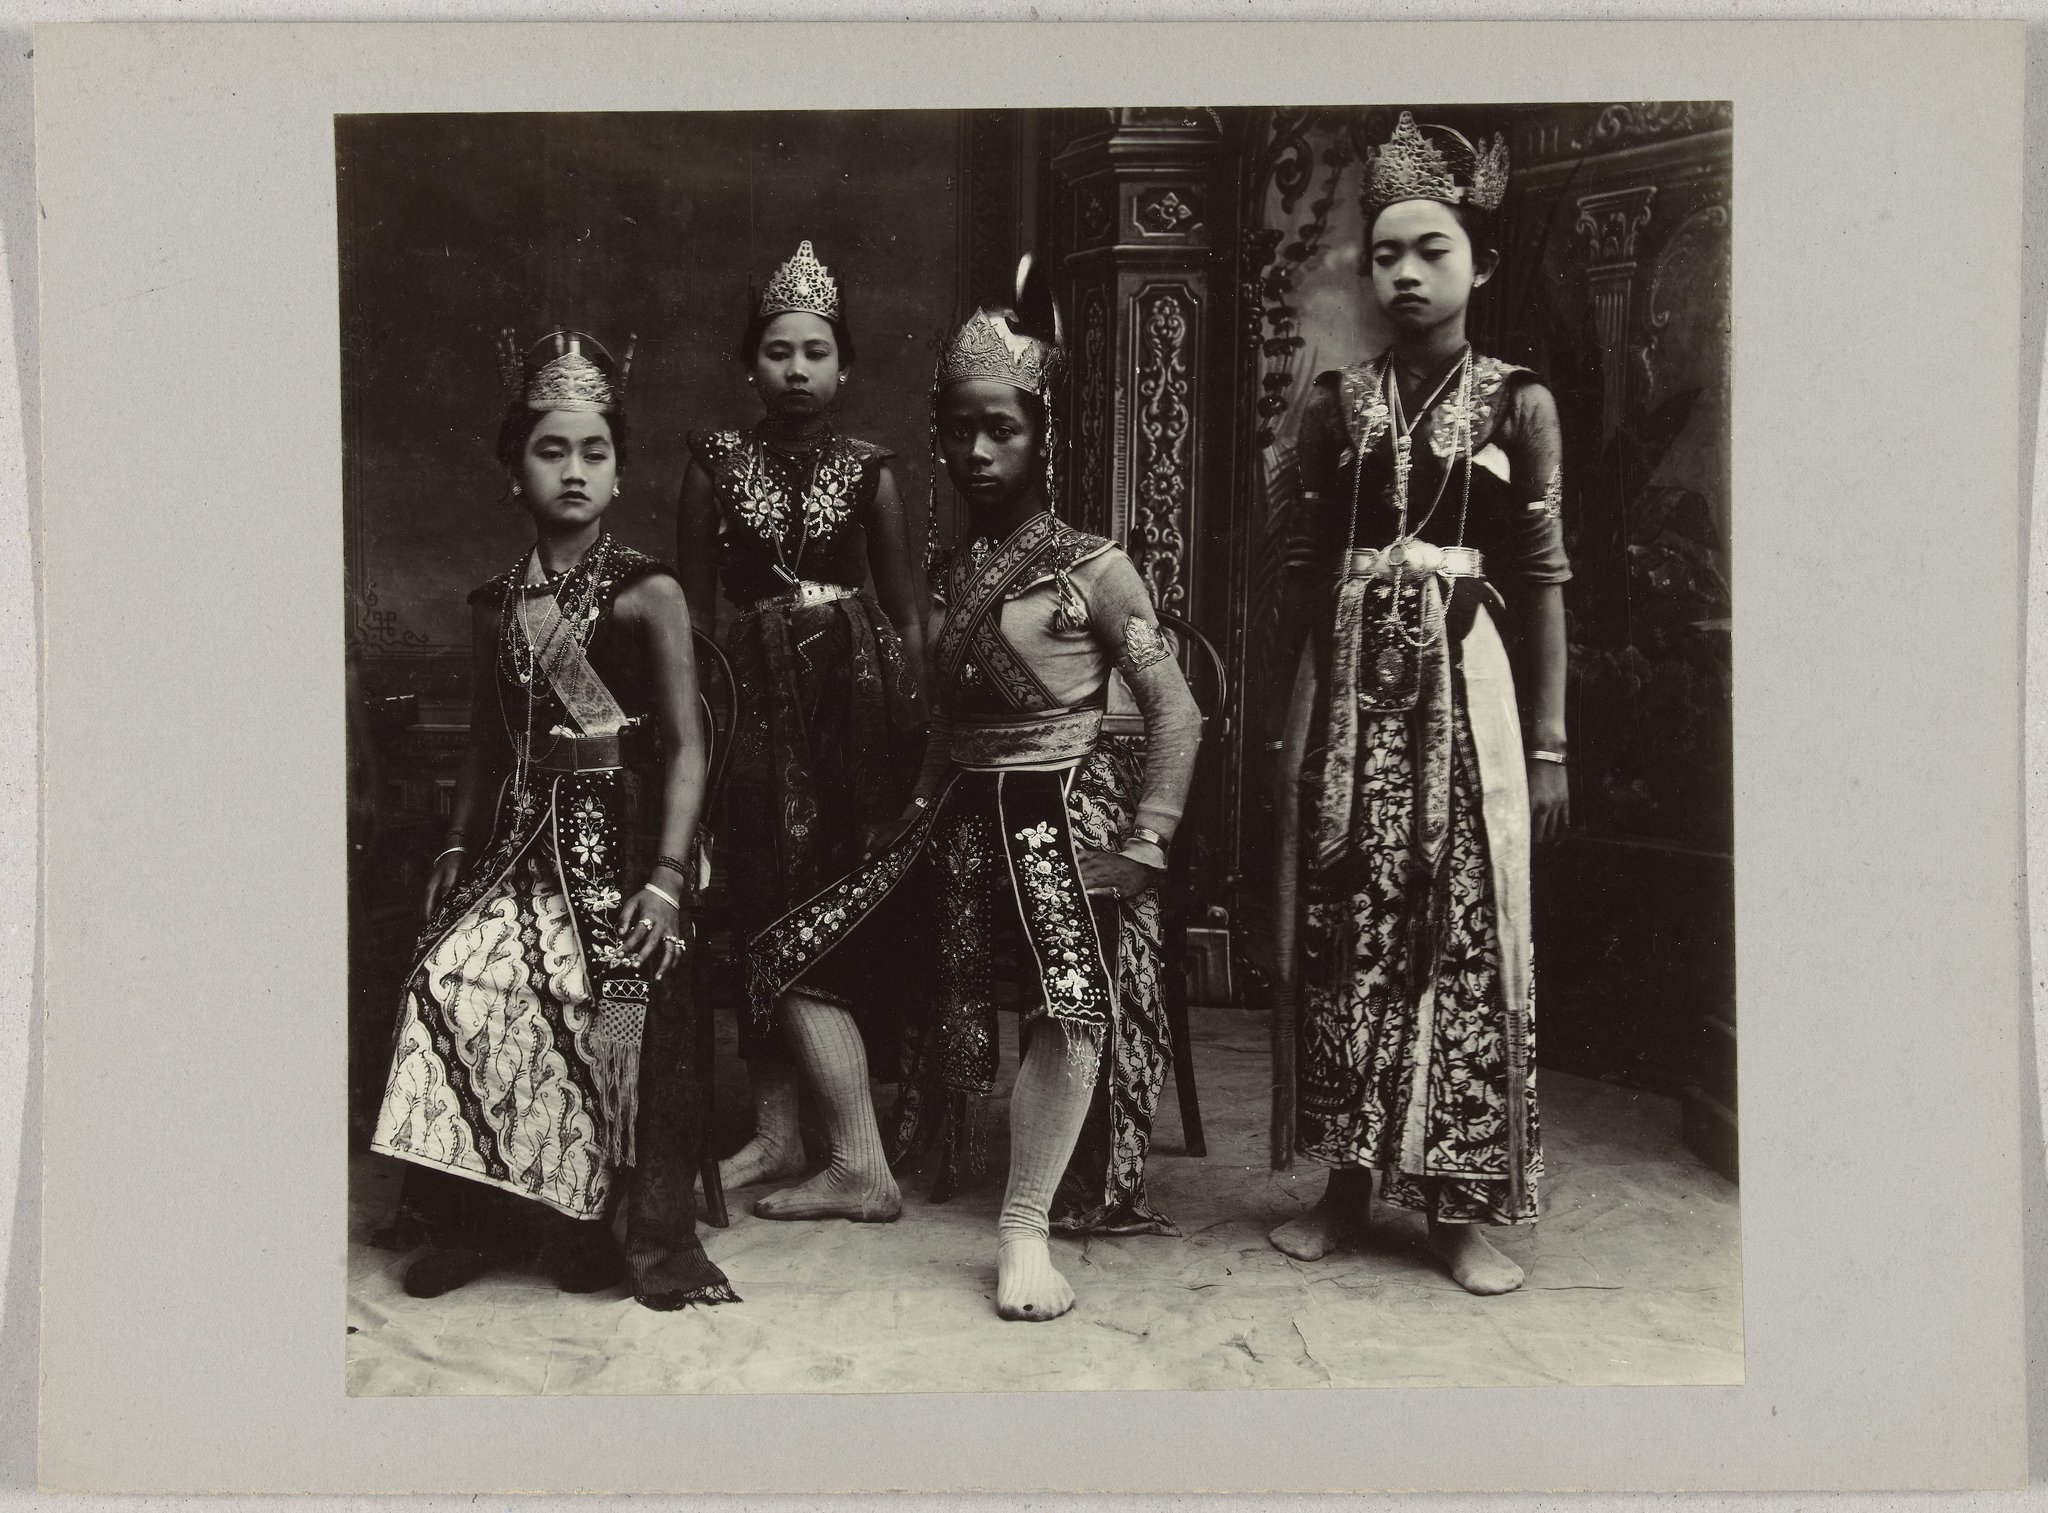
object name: photograph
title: Studioportret van een jongen en drie meisjes in feestelijke kledij in Nederlands-Indië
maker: Anonymous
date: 1895-1915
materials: cardboard, paper, photographic support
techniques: gelatin silver print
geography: dutch east indies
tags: indonesia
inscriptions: number: ‘41’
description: Portret van een jongen en drie meisjes in feestelijke kledij in een geschilderd decor van een paleis, gemaakt in een studio, Nederlands-Indië.